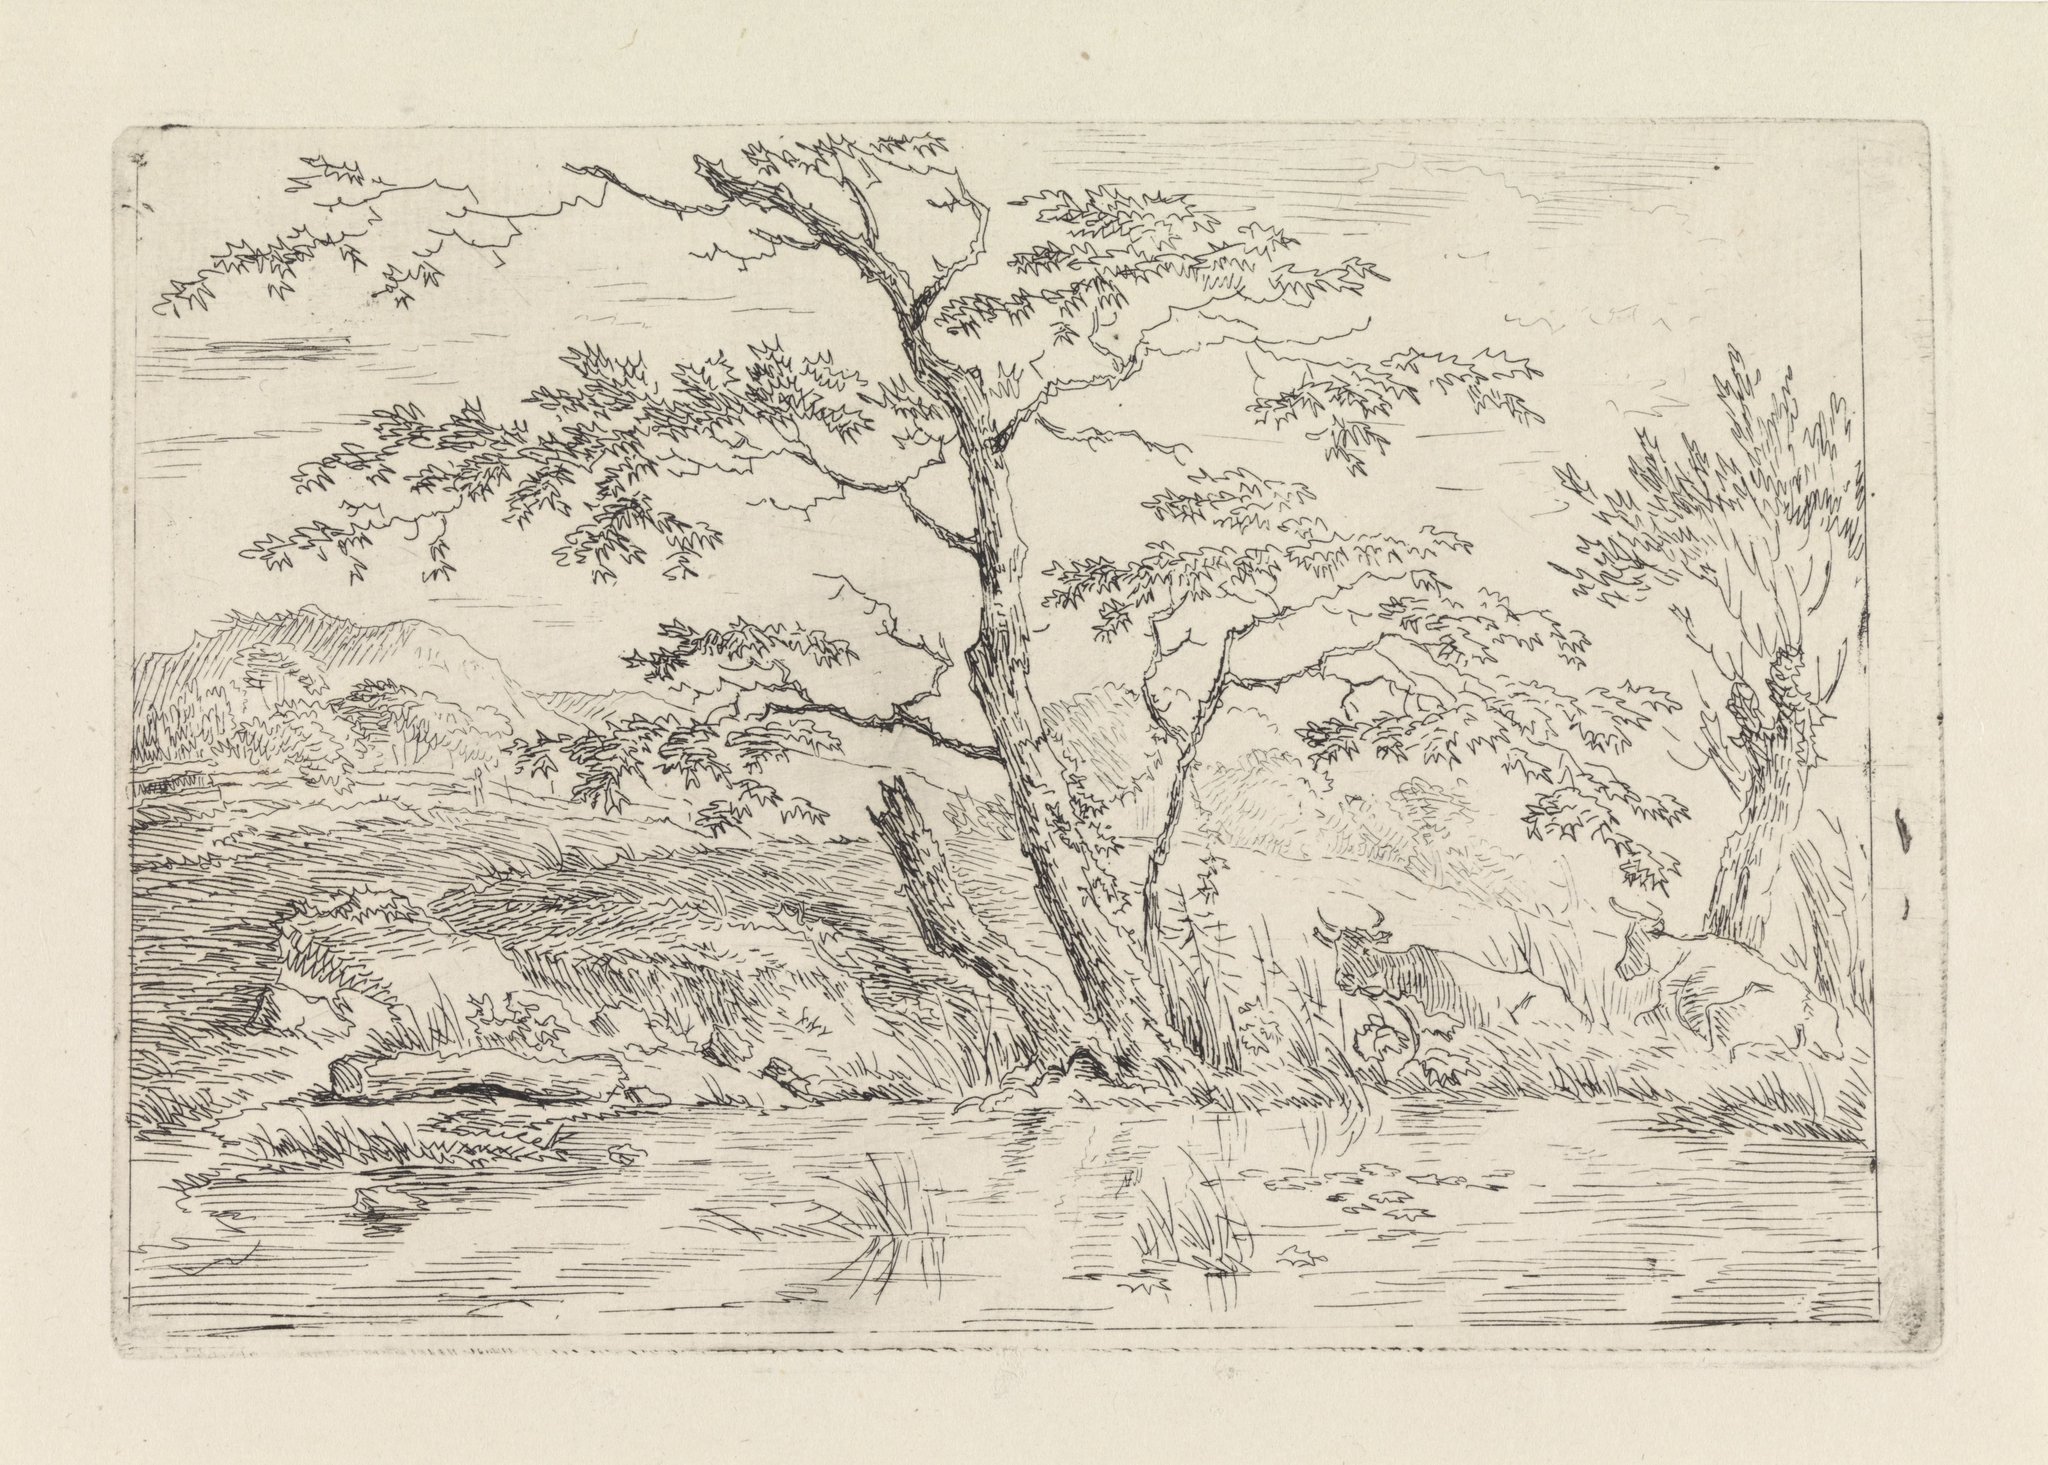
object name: print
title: Landschap met koeien bij het water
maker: gerard van nijmegen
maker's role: draughtsman, painter, print maker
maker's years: 1735-1808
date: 1790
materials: paper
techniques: etching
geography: rotterdam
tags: cow, water course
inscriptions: collector's mark: Lugt 2228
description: Twee koeien liggen aan de waterkant. In het midden aan het water staat een boom.